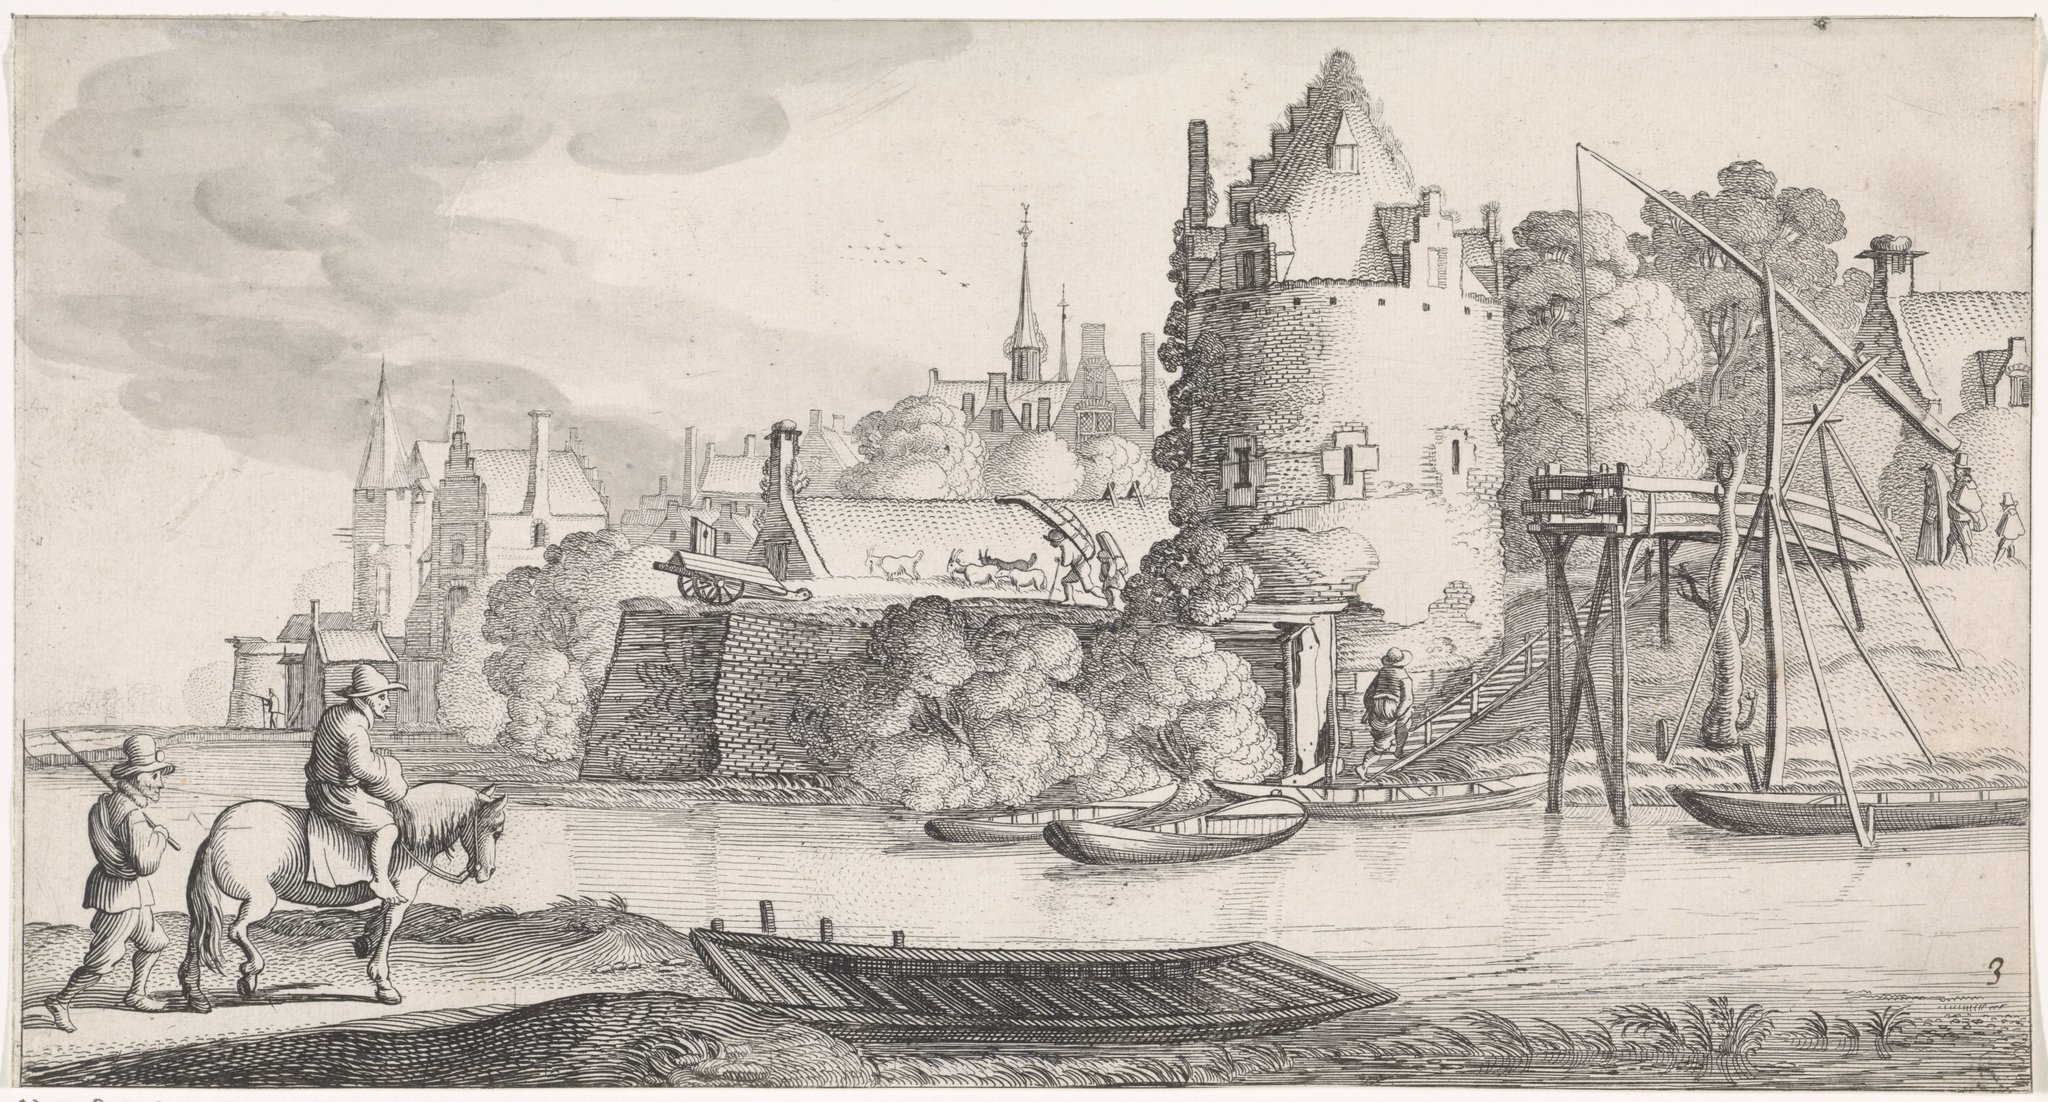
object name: print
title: Stad aan een rivier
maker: jan van de velde (ii)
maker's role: draughtsman, painter, print maker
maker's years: 1593-1641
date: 1639-1641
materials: ink, paper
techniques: brush, etching, pen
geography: northern netherlands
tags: riding a horse, ass, or mule; rider, horseman, river, landscape with tower or castle, ferry, prospect of city, town panorama, silhouette of city (+ city(-scape) with figures, staffage)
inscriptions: number: ‘3’, collector's mark: Lugt 2228, collector's mark: Lugt 1120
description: Een ruiter en een wandelaar bij een pont, bij een stad aan een rivier. Derde prent van een serie met 36 prenten van landschappen, verdeeld over zes delen.